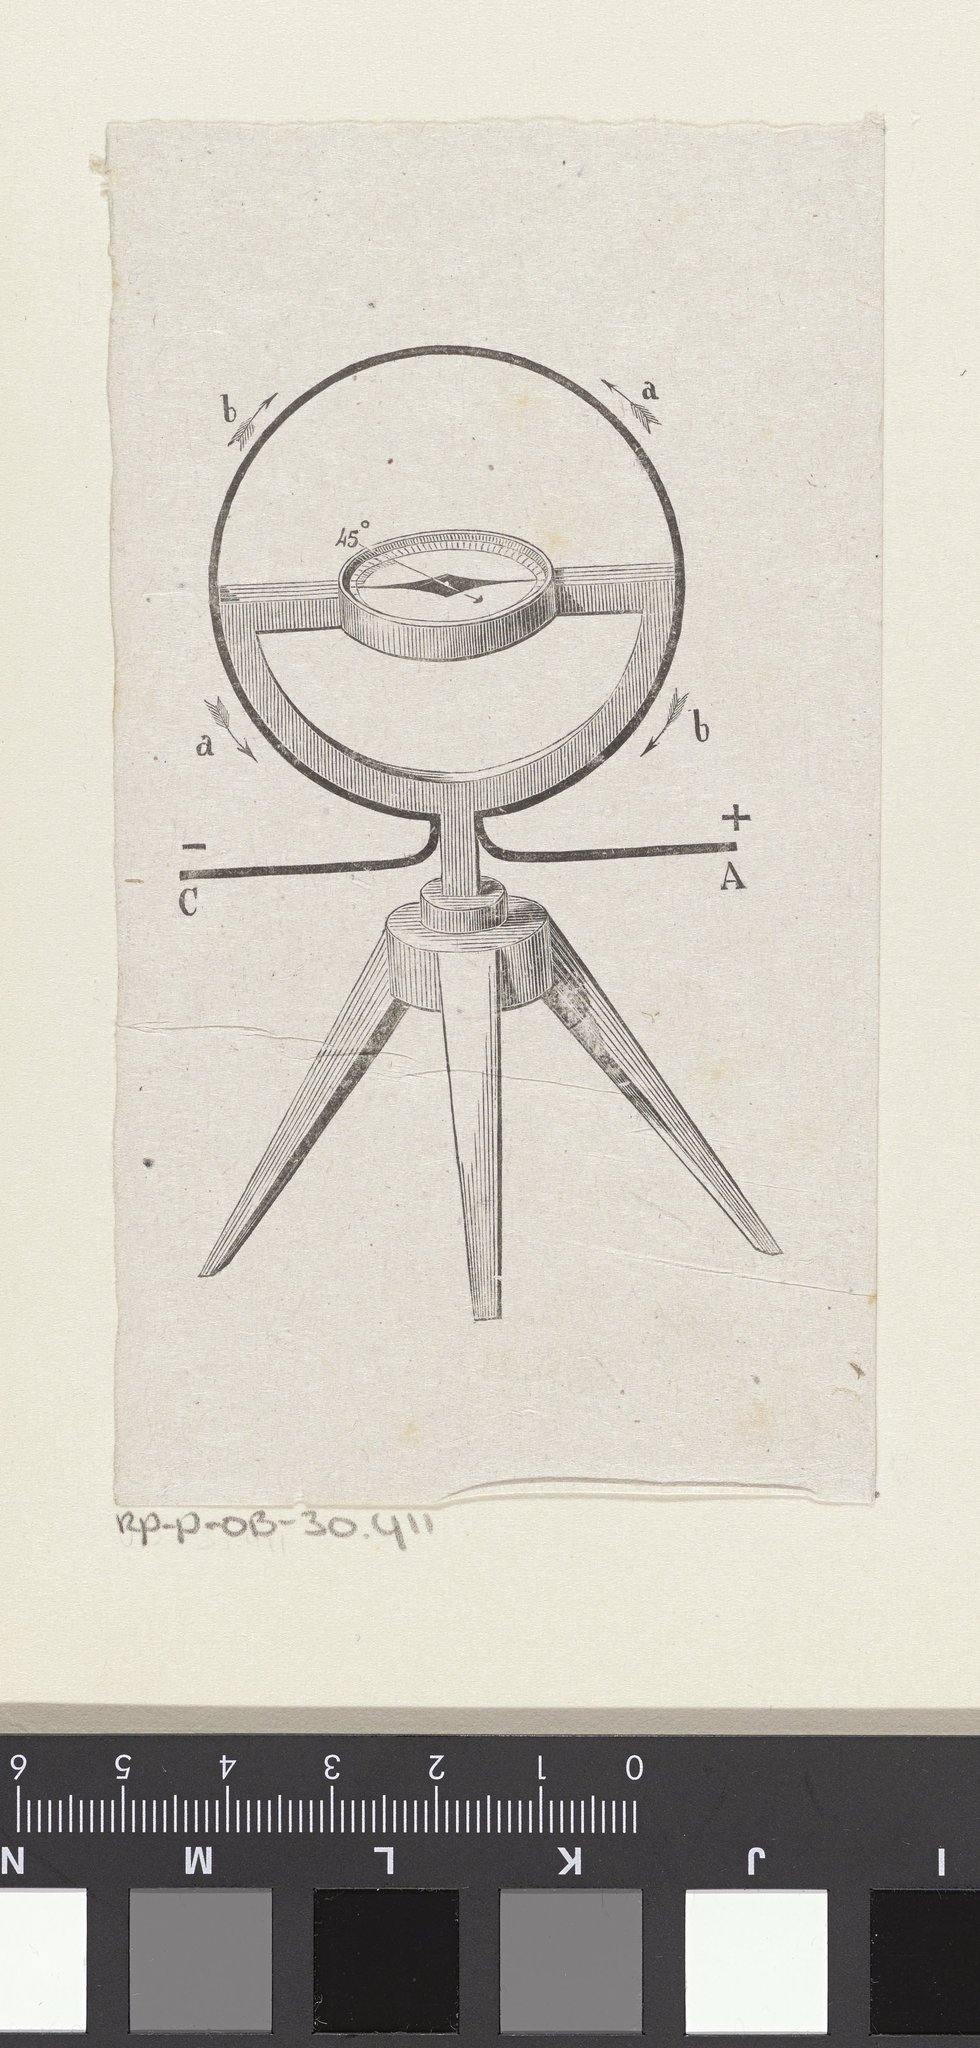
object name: print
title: Kompas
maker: isaac weissenbruch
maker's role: print maker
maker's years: 1826-1912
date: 1836-1912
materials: paper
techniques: engraving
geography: netherlands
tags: compass